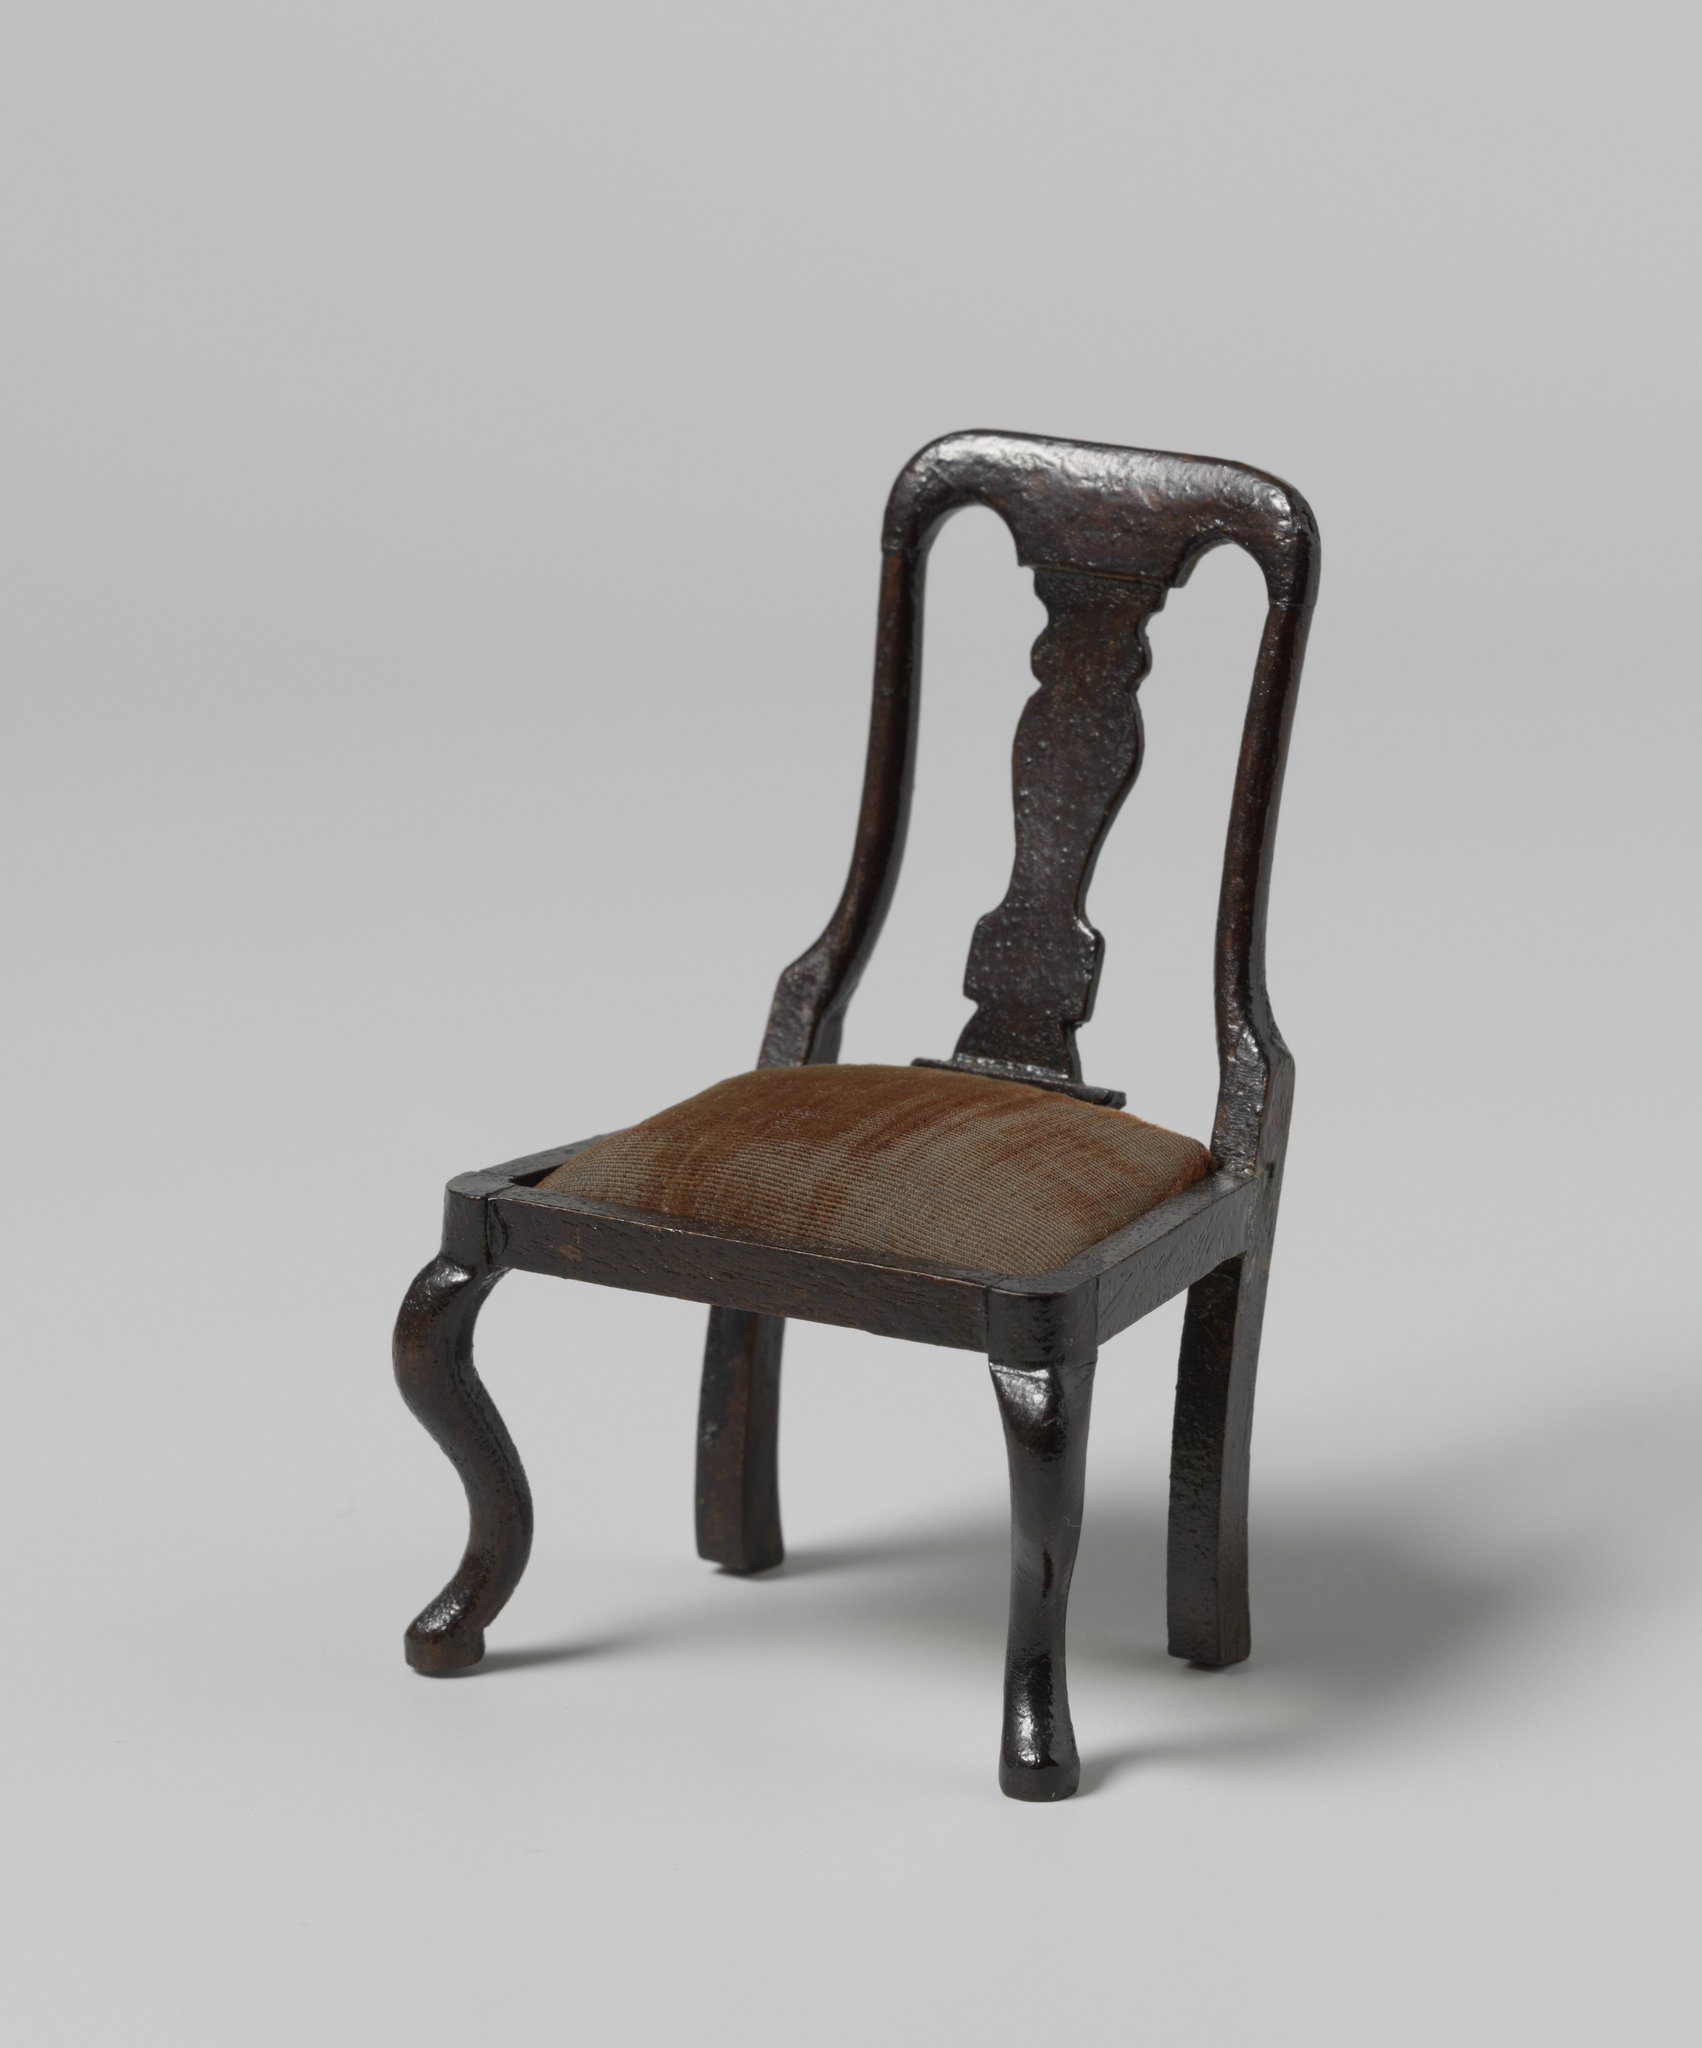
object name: miniature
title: Stoel, de rug met vaasvormig middenblad, de zitting met bordeauxrode fluweel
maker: Anonymous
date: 1800-1899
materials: wood, velvet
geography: amsterdam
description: Stoel van mahoniehout. De rug is open met een vaasvormig middenblad. De stoel heeft een trapezium-vormig open zitraam met losse zitting met bordeauxrode fluweel.